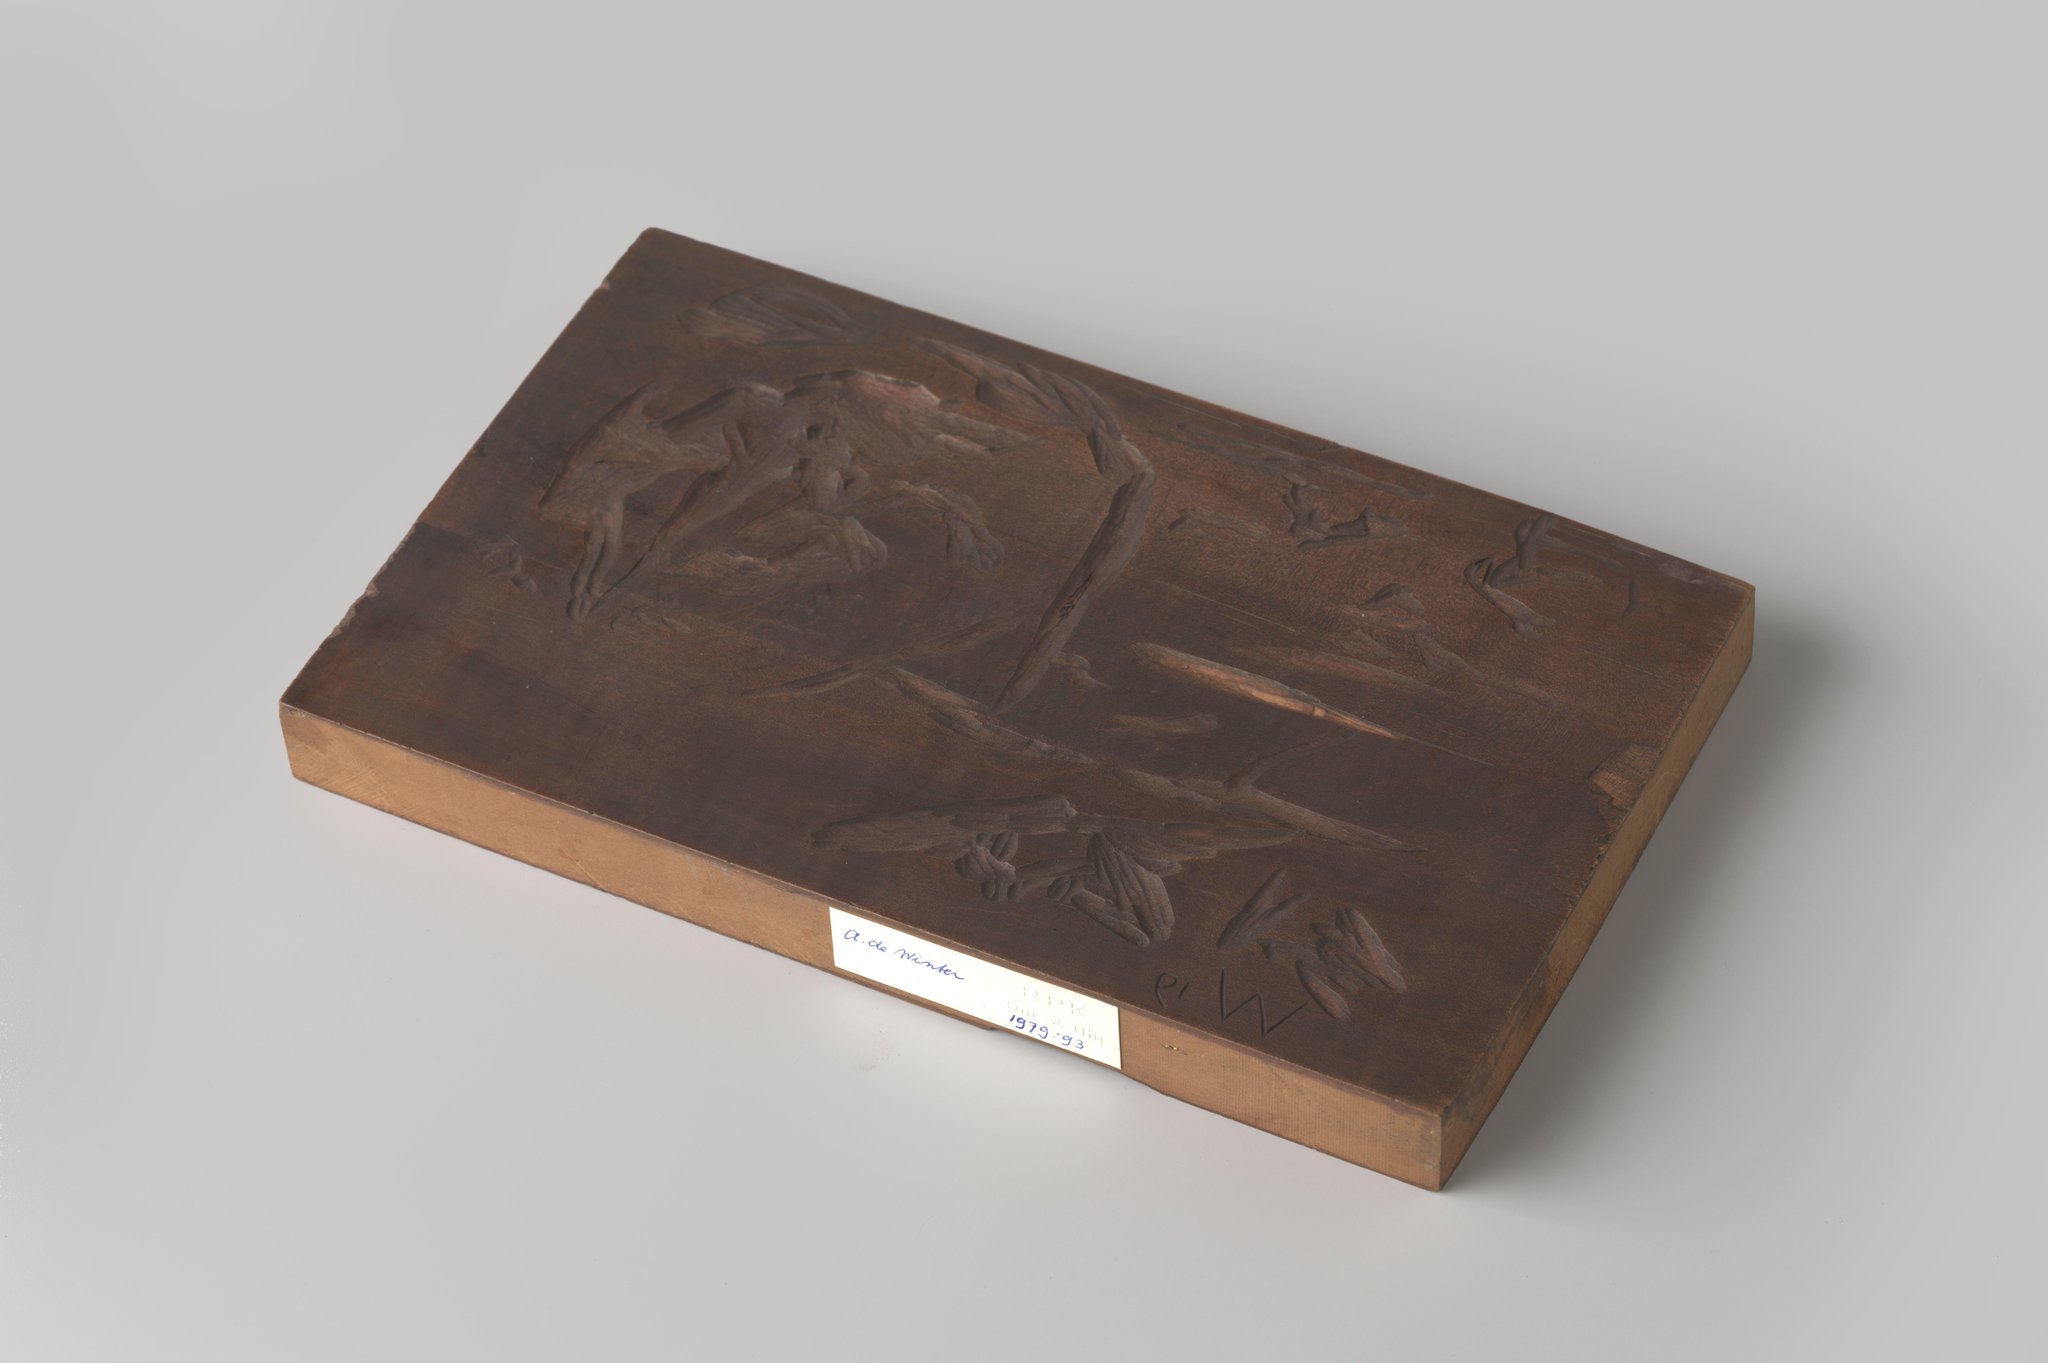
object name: wood block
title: Abstracte compositie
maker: a. de winter (prentmaker)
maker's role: print maker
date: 1919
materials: wood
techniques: woodcut